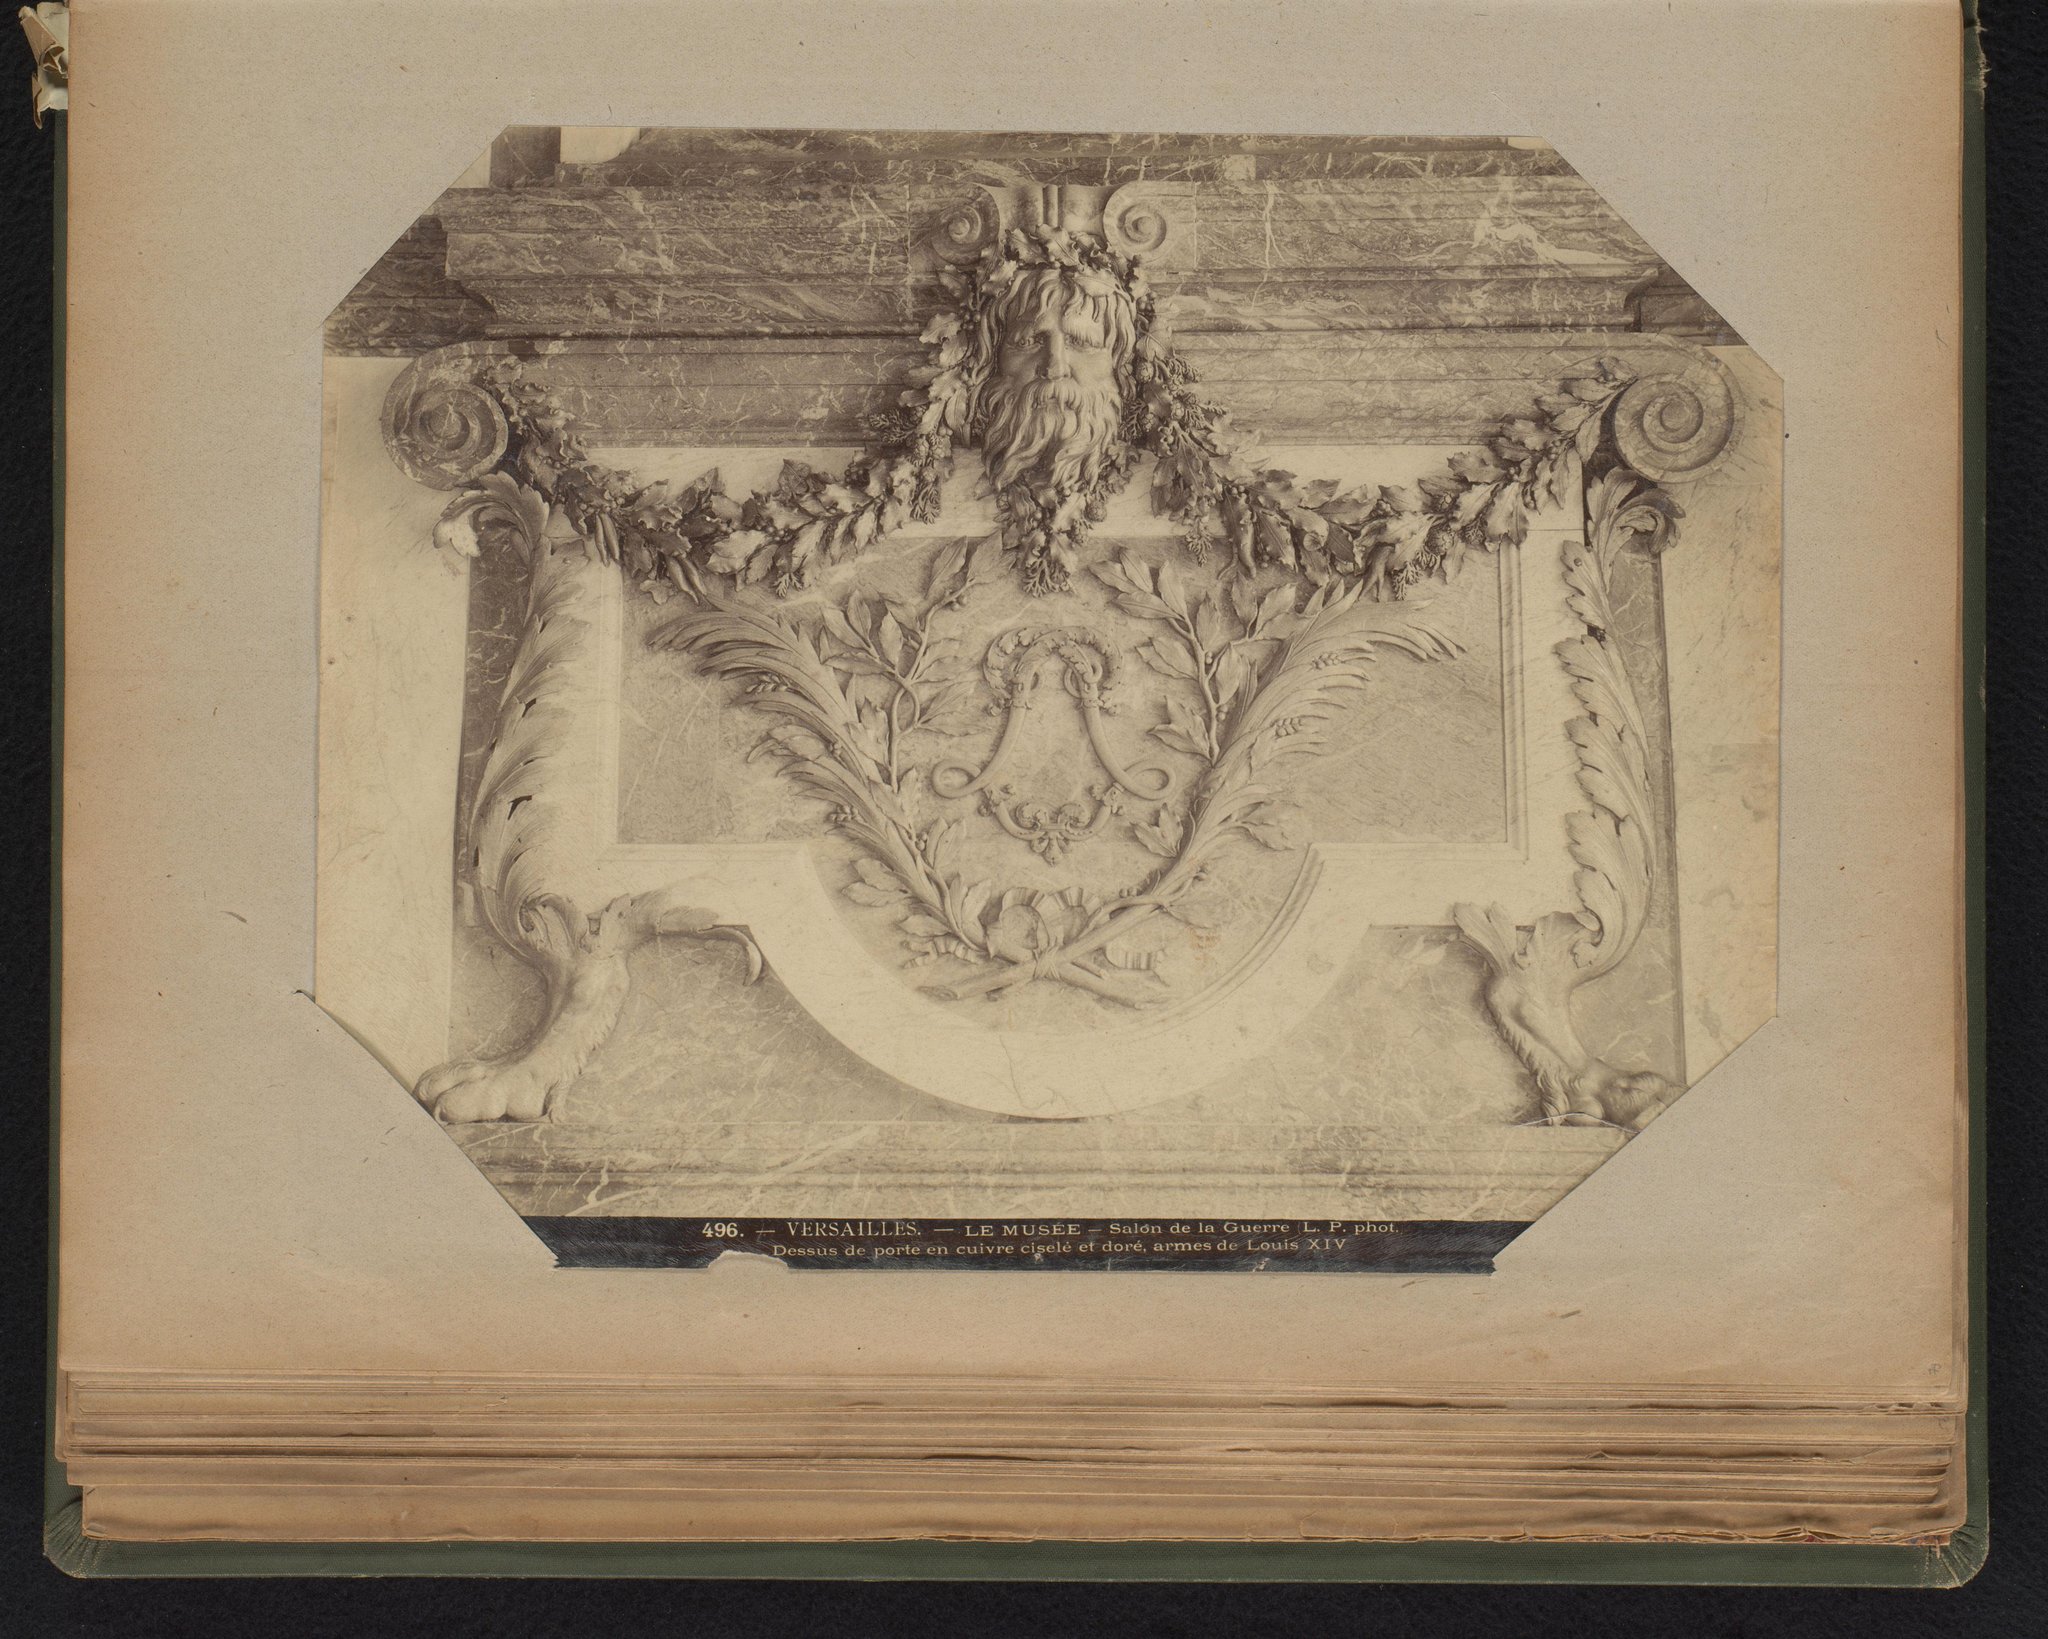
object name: photograph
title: Koperen en verguld ornament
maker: Anonymous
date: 1860-1900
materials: paper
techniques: albumen print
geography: france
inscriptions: annotation: ‘496. - Versailles - Le Musee - Salon de la Guerre (L.P. Phot). Dessus de porte en cuivre cisele et doré, armes de Louis XIV.’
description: Het ornament bestaat uit een mannenhoofd, een krans en een familiewapen en het geheel rustend op leeuwenpoten. Onderdeel van een serie met betrekking tot het interieur van het paleis van Versailles met kroonluchters, deuren, portalen en meubelstukken.